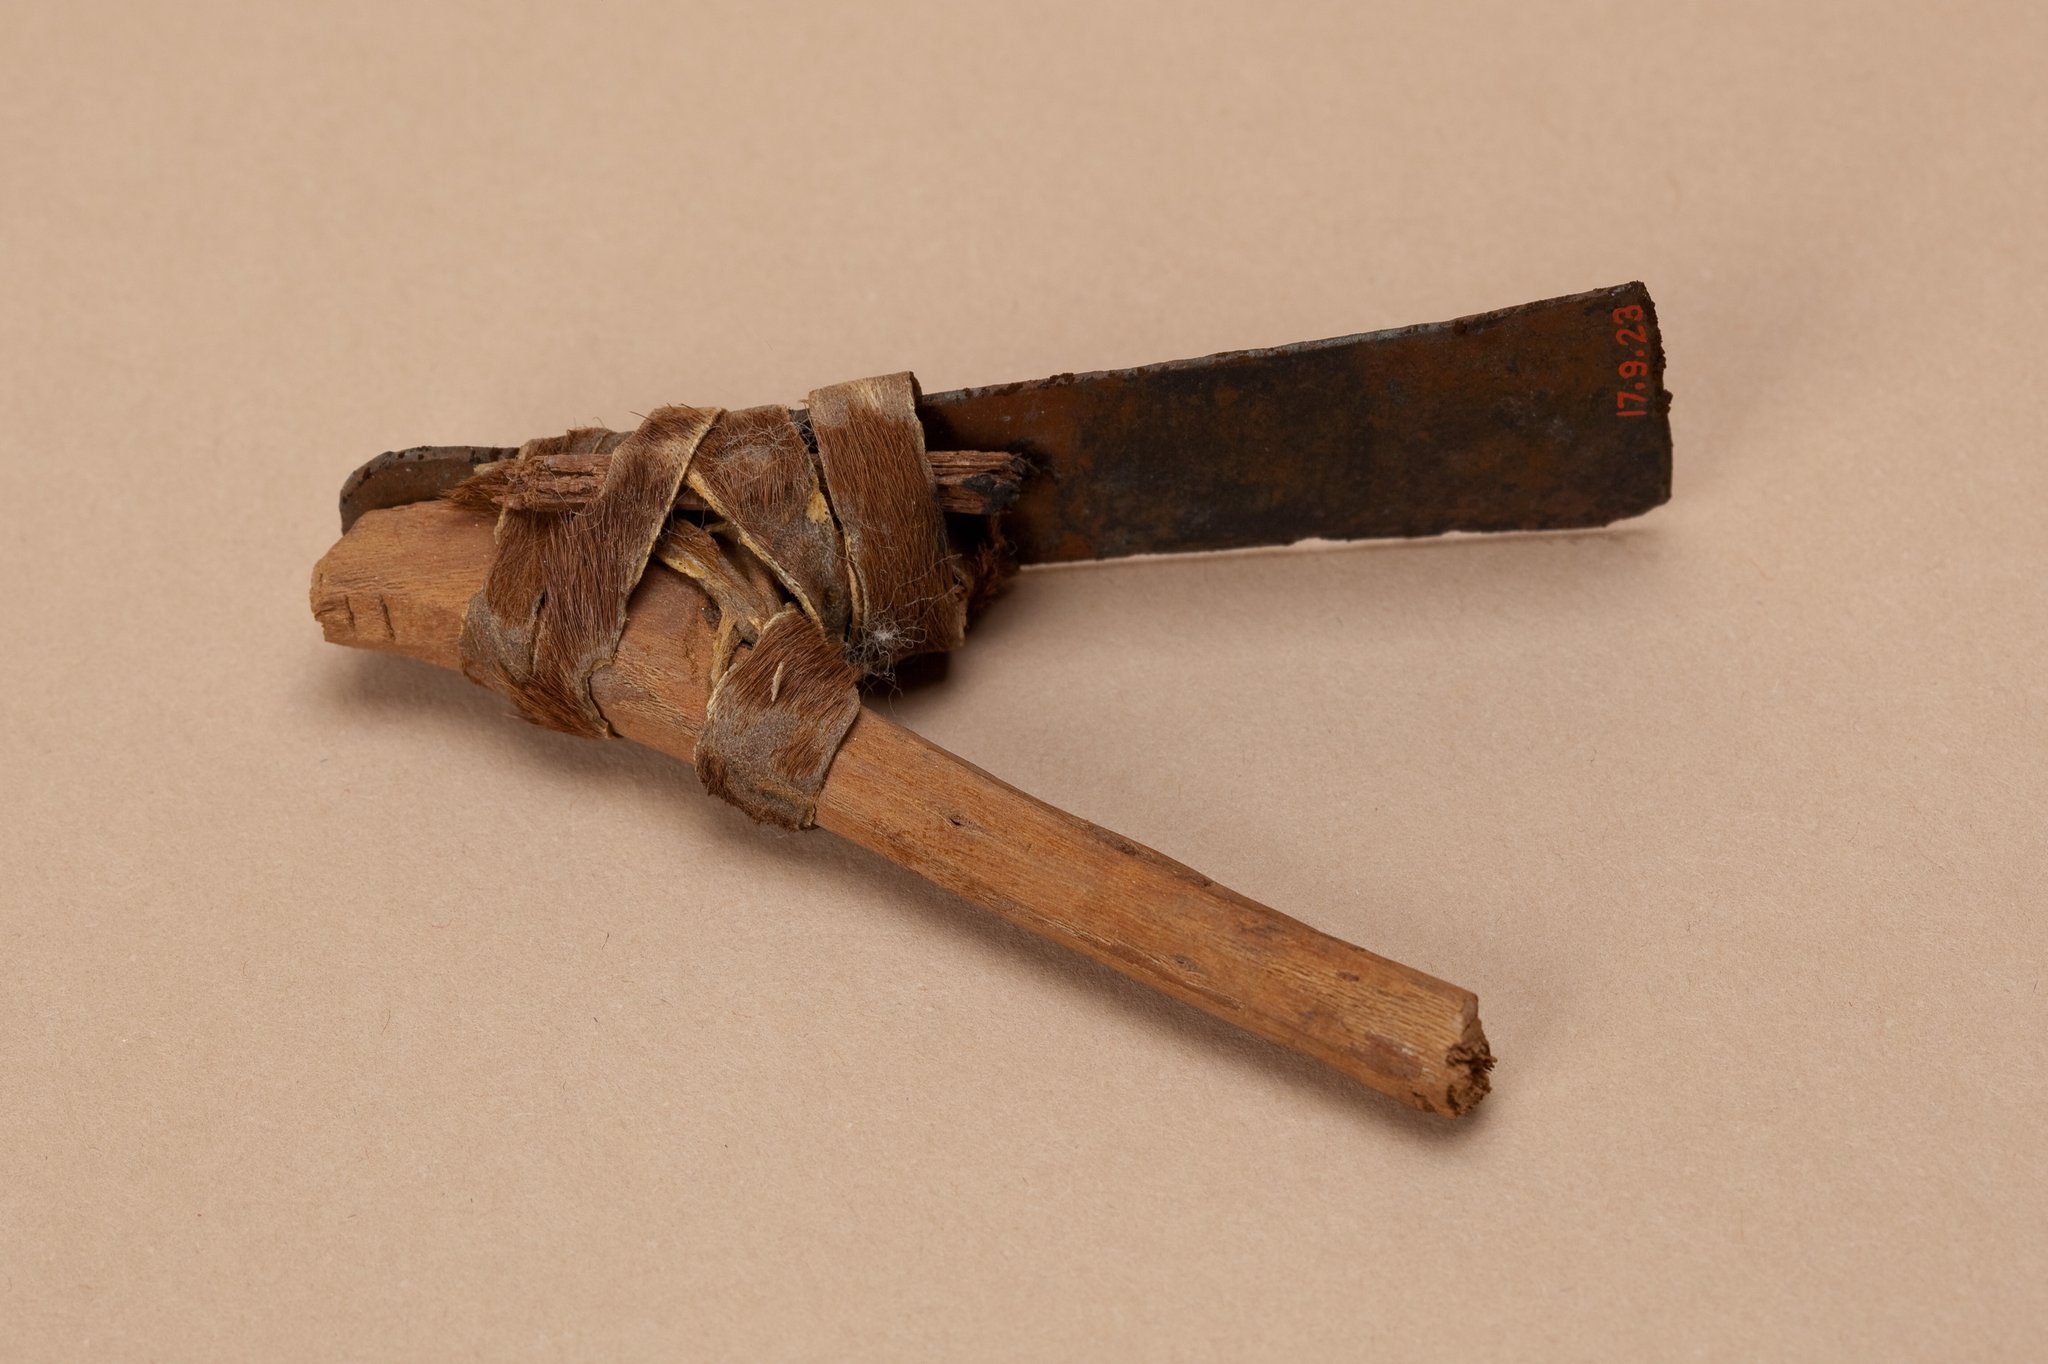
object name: model adze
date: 1981-1802 BCE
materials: copper, wood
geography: egypt